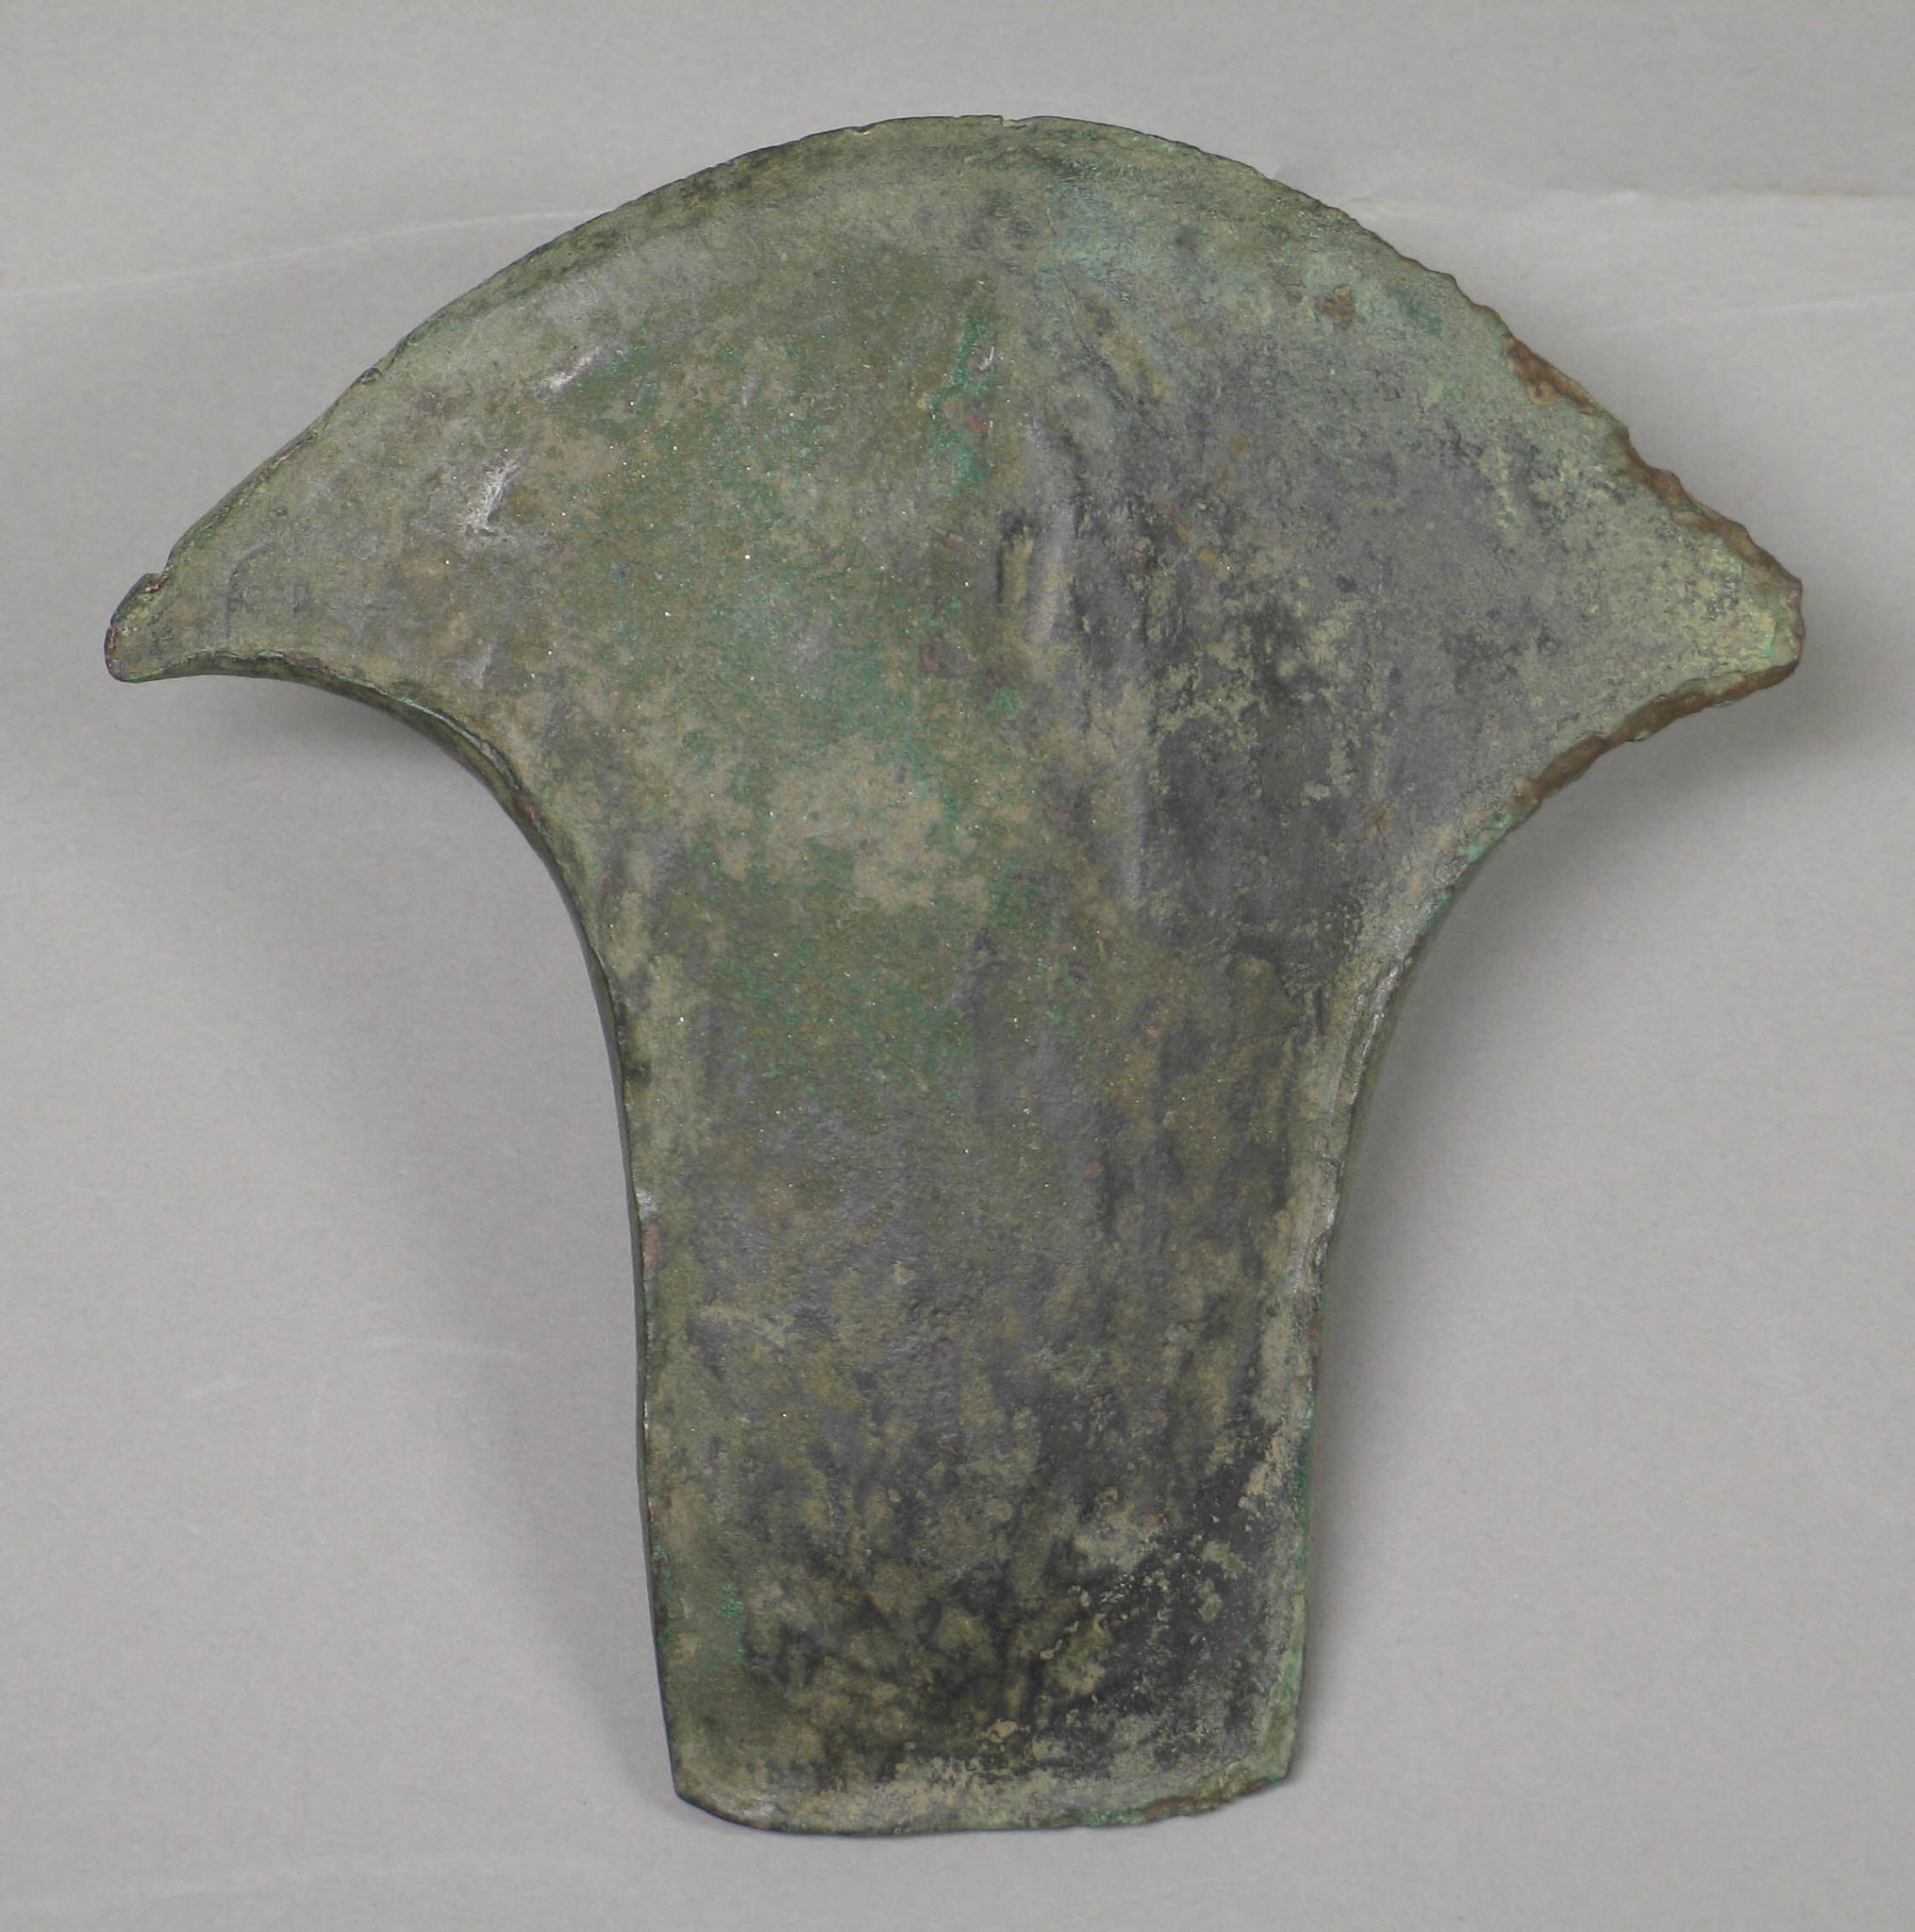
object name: ax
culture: indian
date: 1500-500 BCE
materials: copper